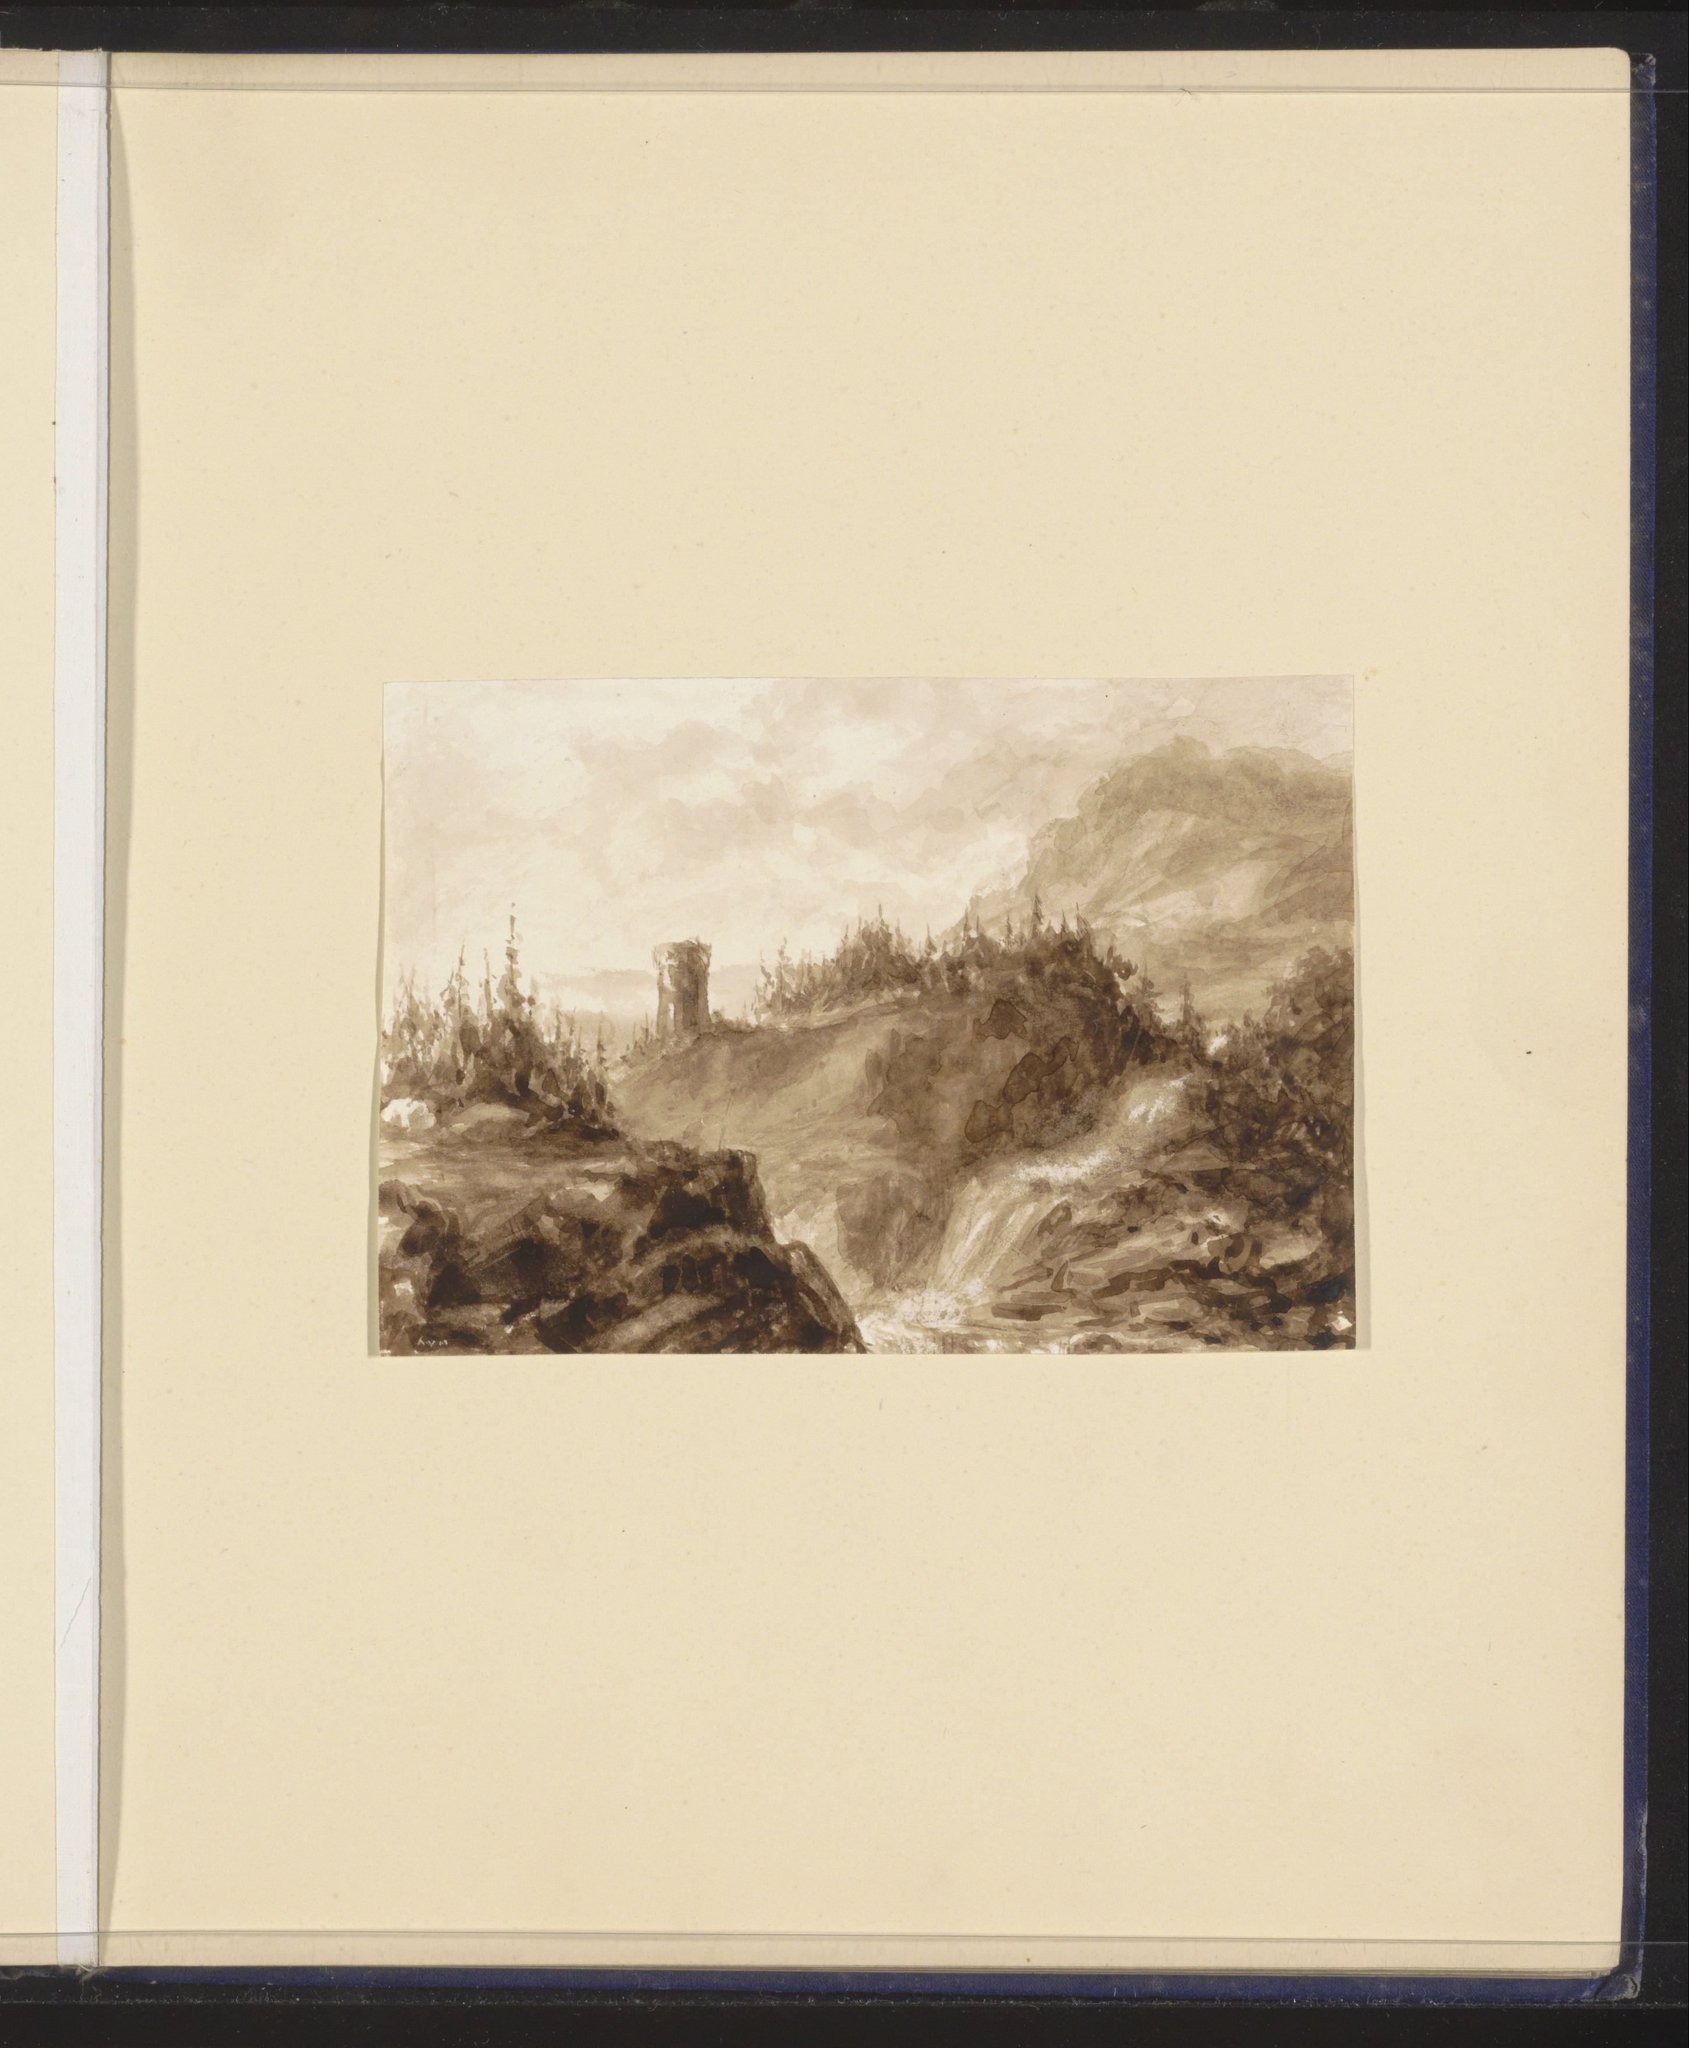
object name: album leaf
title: Berglandschap met een waterval en toren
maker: alexander ver huell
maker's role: draughtsman, print maker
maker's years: 1822-1897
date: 1882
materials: paper, watercolor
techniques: brush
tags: waterfall, forest, wood, mountains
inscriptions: signature: ‘AVH’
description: Tekening op blad 2 van een album met 24 ingeplakte schetsen.